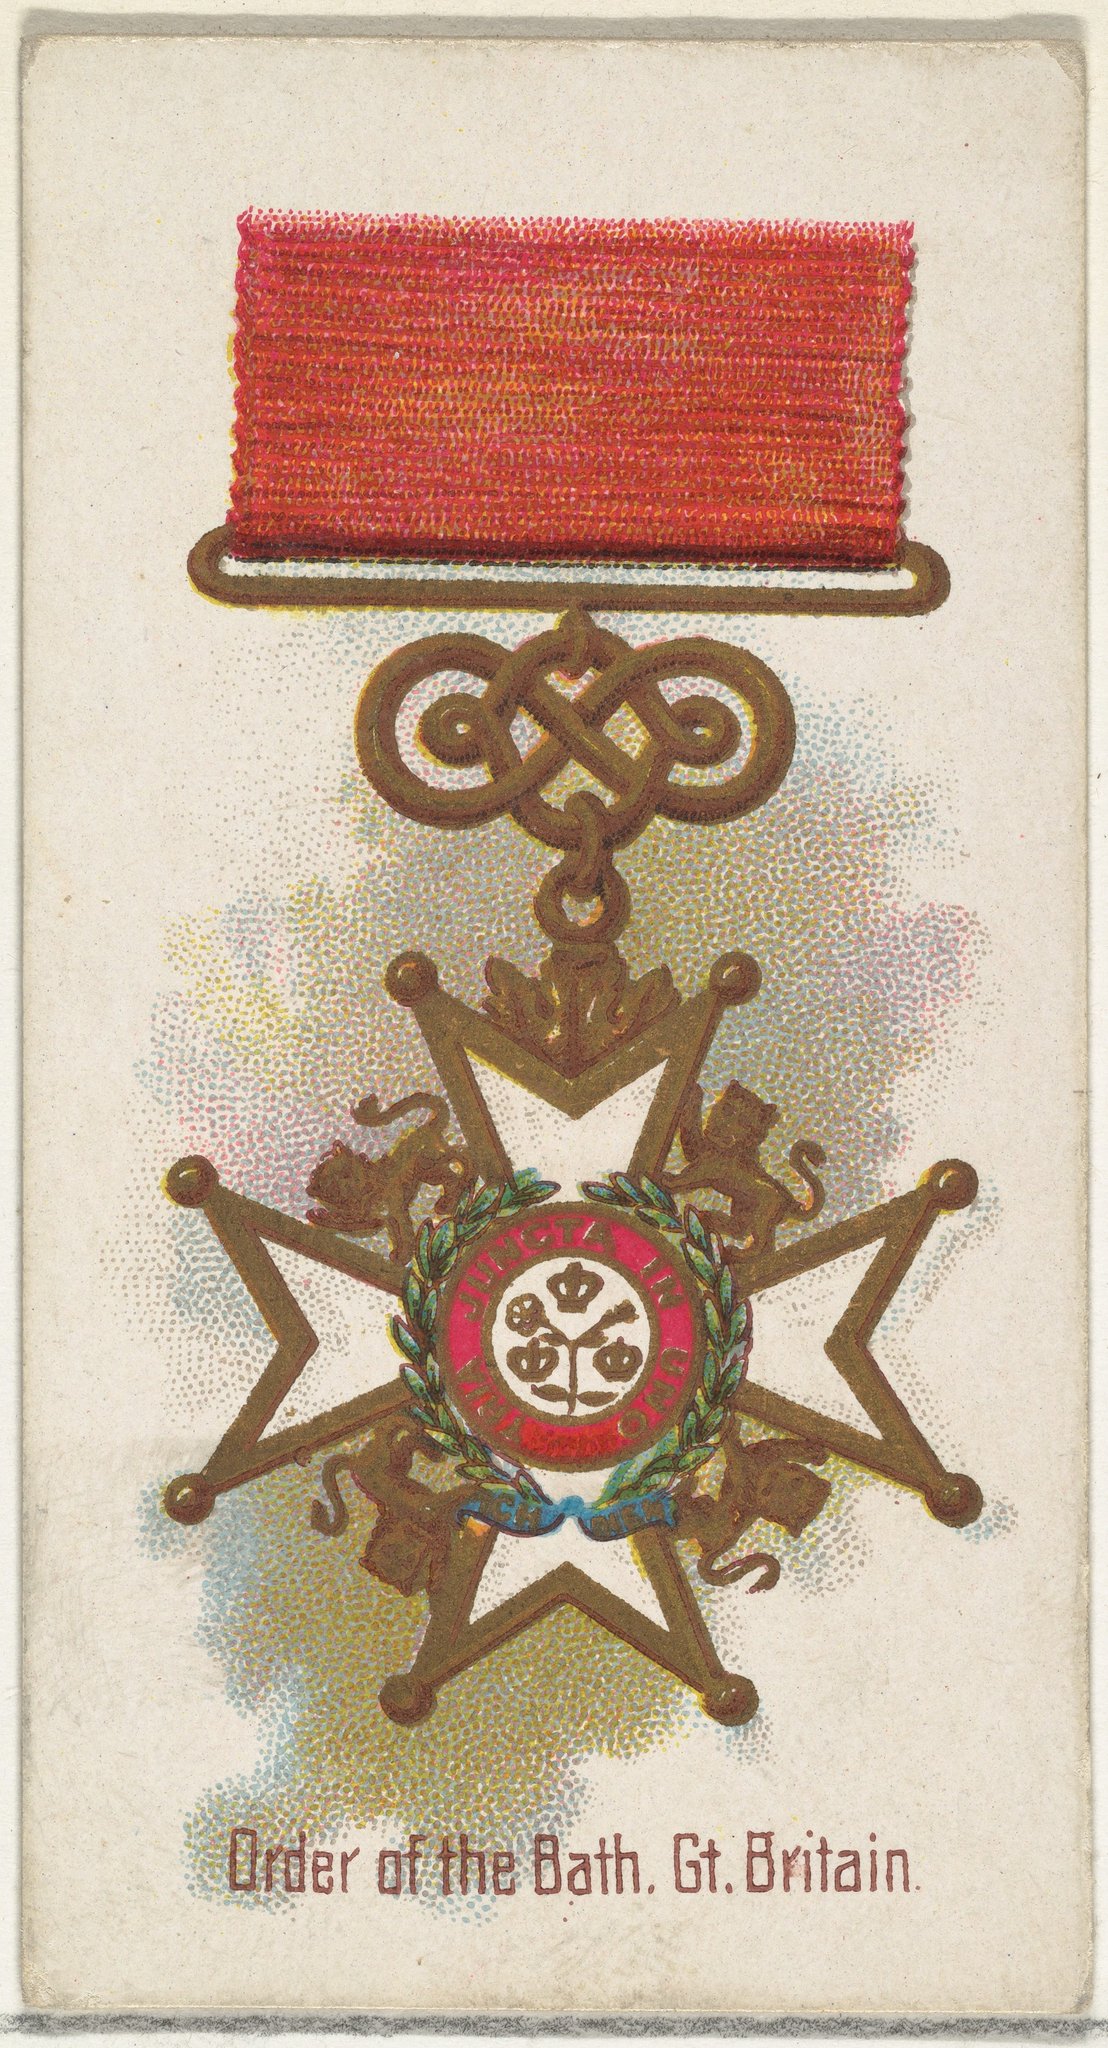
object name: print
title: Order of the Bath, Great Britain, from the World's Decorations series (N30) for Allen & Ginter Cigarettes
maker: allen & ginter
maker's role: publisher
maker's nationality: american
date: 1890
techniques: color lithograph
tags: medals